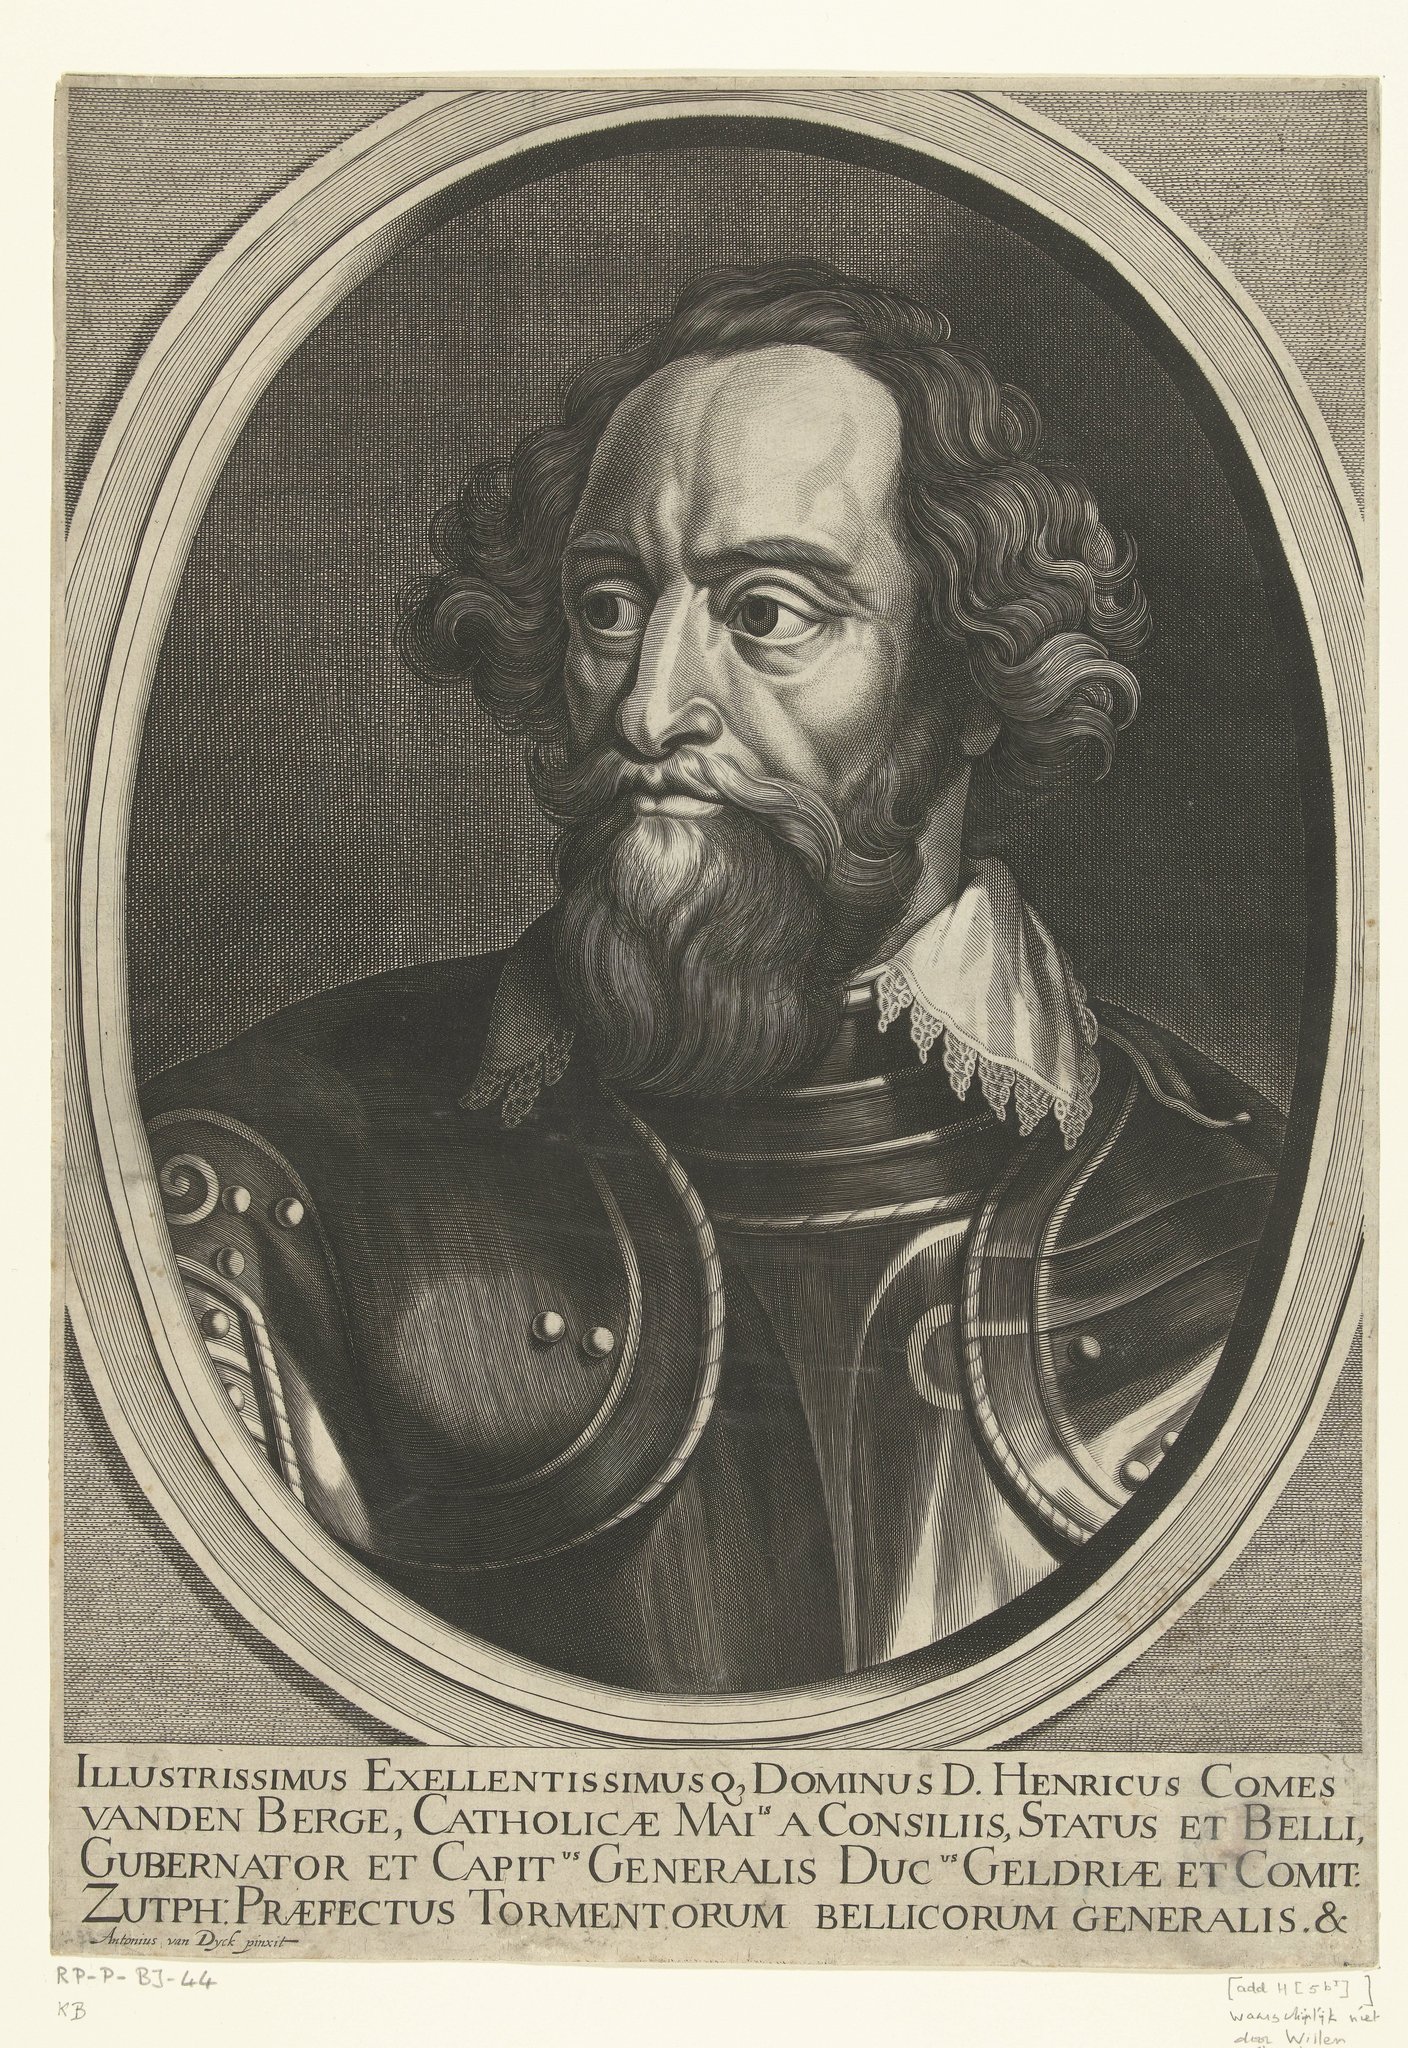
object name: print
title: Portret van Hendrik graaf van den Bergh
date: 1610-1651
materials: paper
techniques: engraving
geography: netherlands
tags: historical persons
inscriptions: collector's mark: Lugt 240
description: Portretbuste met het hoofd naar links, blootshoofds, in een harnas, in een ovale lijst. In de marge een Latijns onderschrift van vier regels: Illustrissimus Excellentissimusq., Dominus D. Henricus Comes vanden Berge [...].